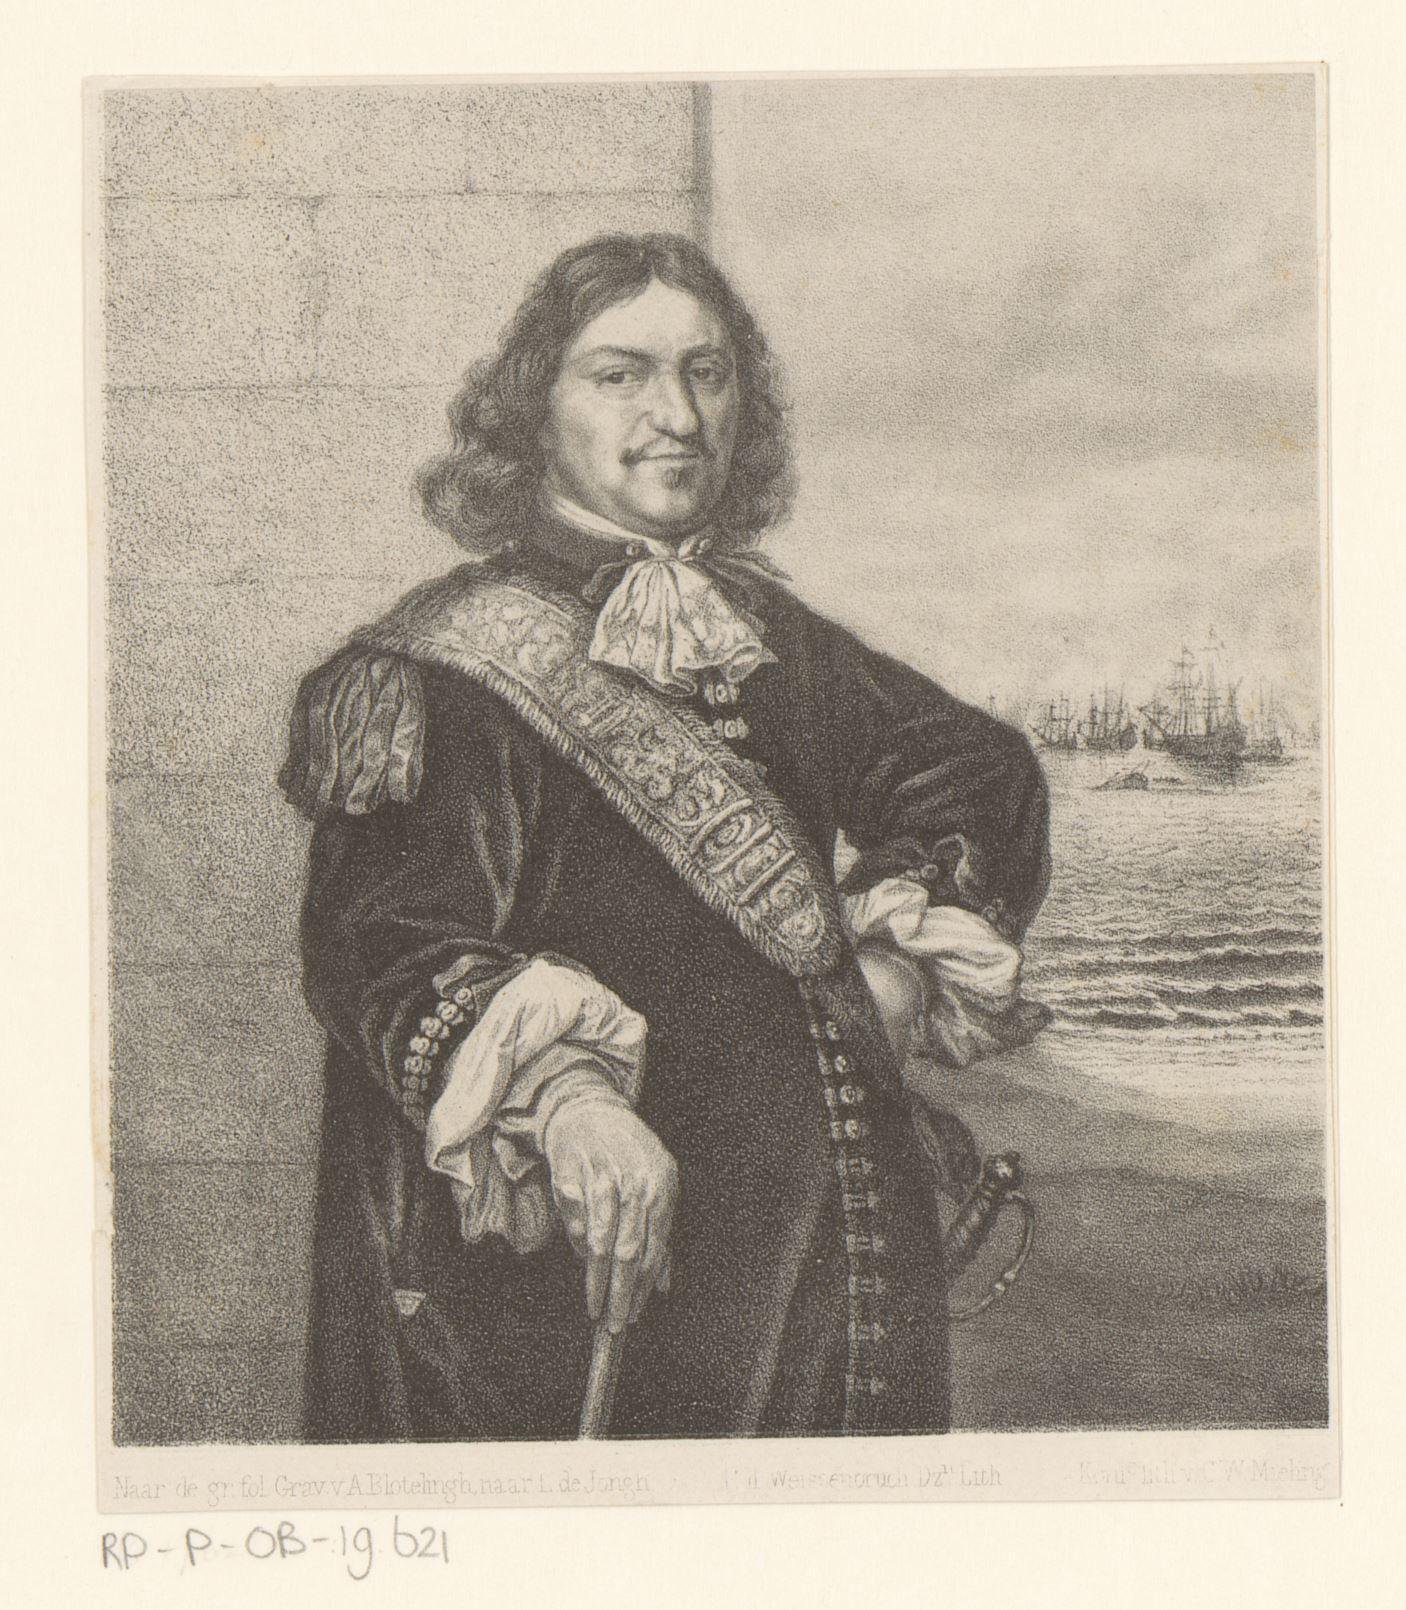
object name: book illustration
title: Portret van Aert Jansz. van Nes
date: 1858-1862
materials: paper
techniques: lithograph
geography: the hague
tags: rotterdam, historical persons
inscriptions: collector's mark: Lugt 2228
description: Prent uit: Jonge, J.C. de. Geschiedenis van het Nederlandsche zeewezen. Haarlem: Jonge, J.K.J. de, 1858-62.